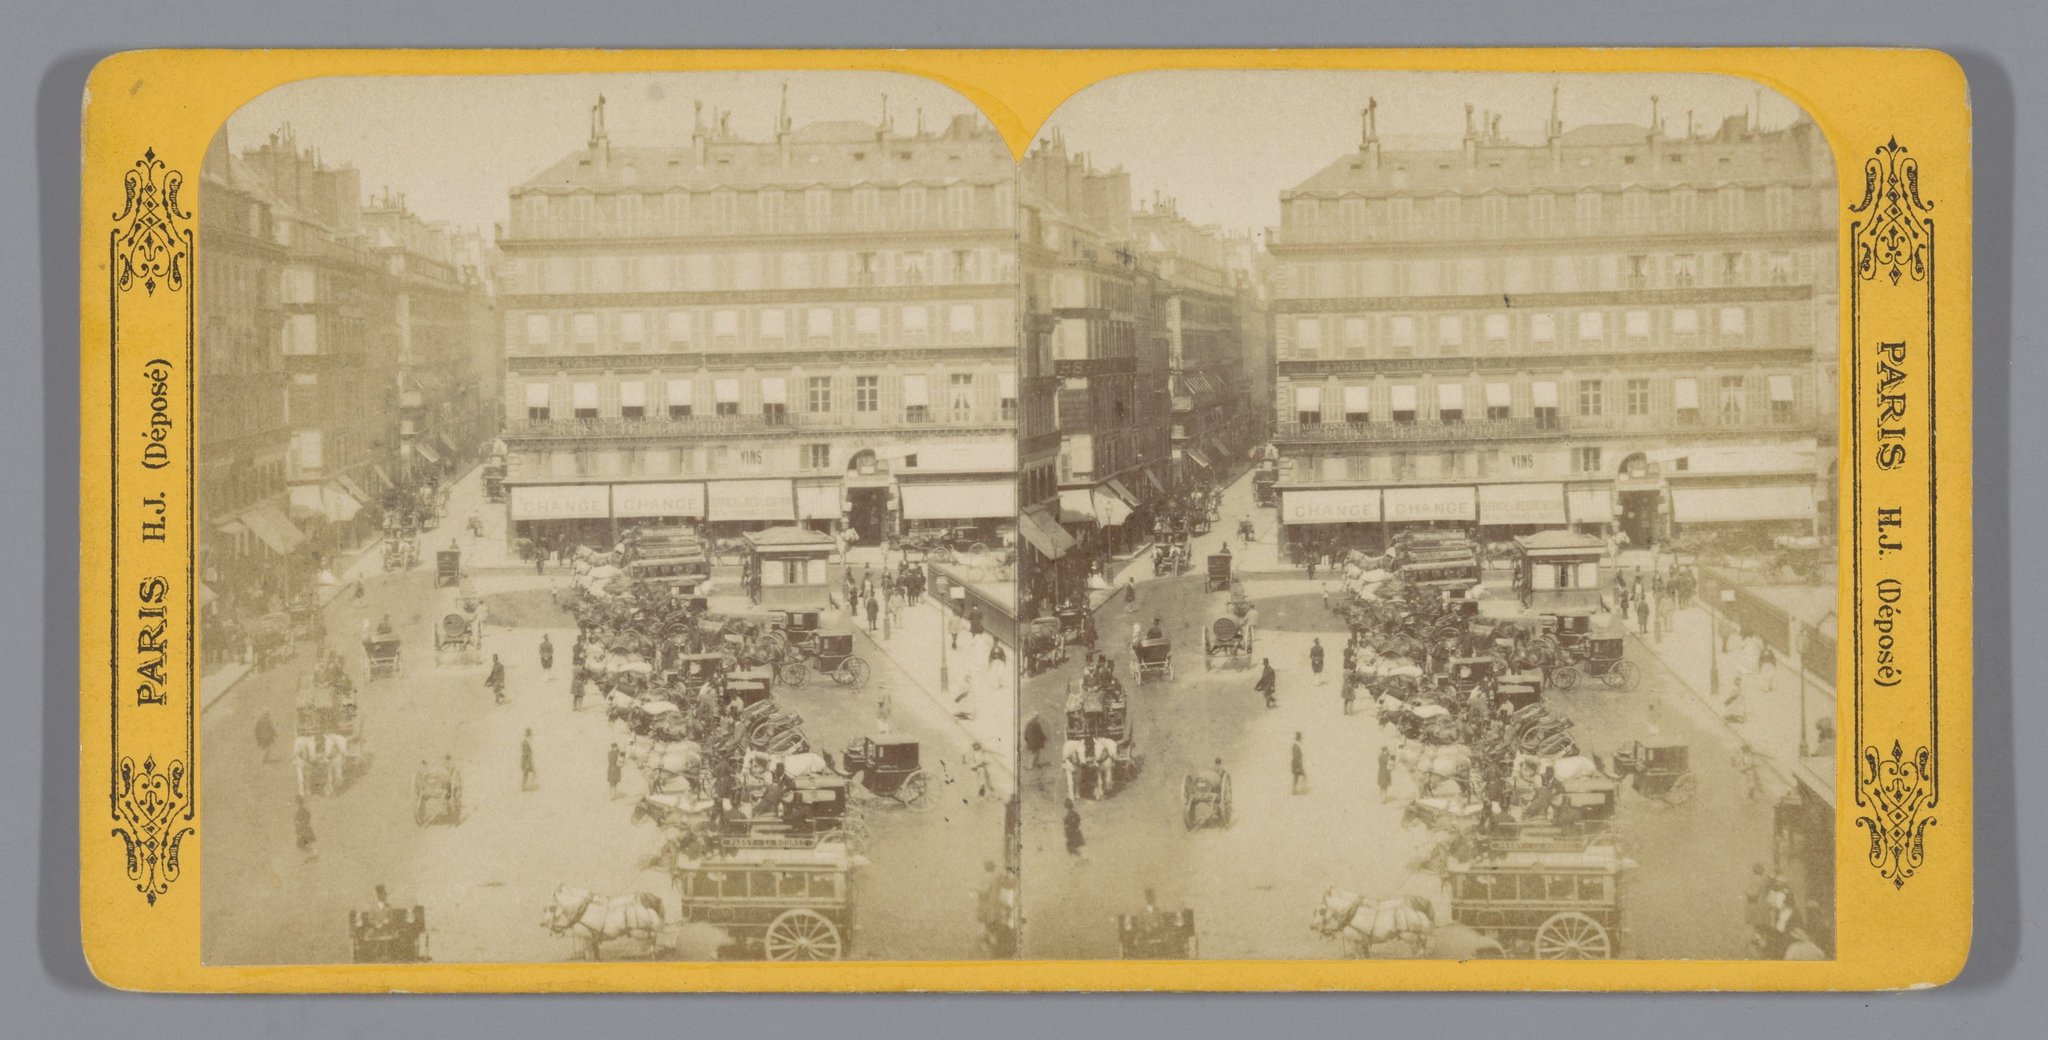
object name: stereograph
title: Vue instantanée de Paris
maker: hippolyte jouvin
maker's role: fotograaf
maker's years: 1825-1889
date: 1863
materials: cardboard, paper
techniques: albumen print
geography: paris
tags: square, place, circus, etc., four-wheeled vehicle drawn by two animals, paris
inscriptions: inscription: ‘Déposé’, inscription: ‘Déposé.’, initials: ‘H.J.’, number: ‘No 89’, inscription: ‘40 ct’